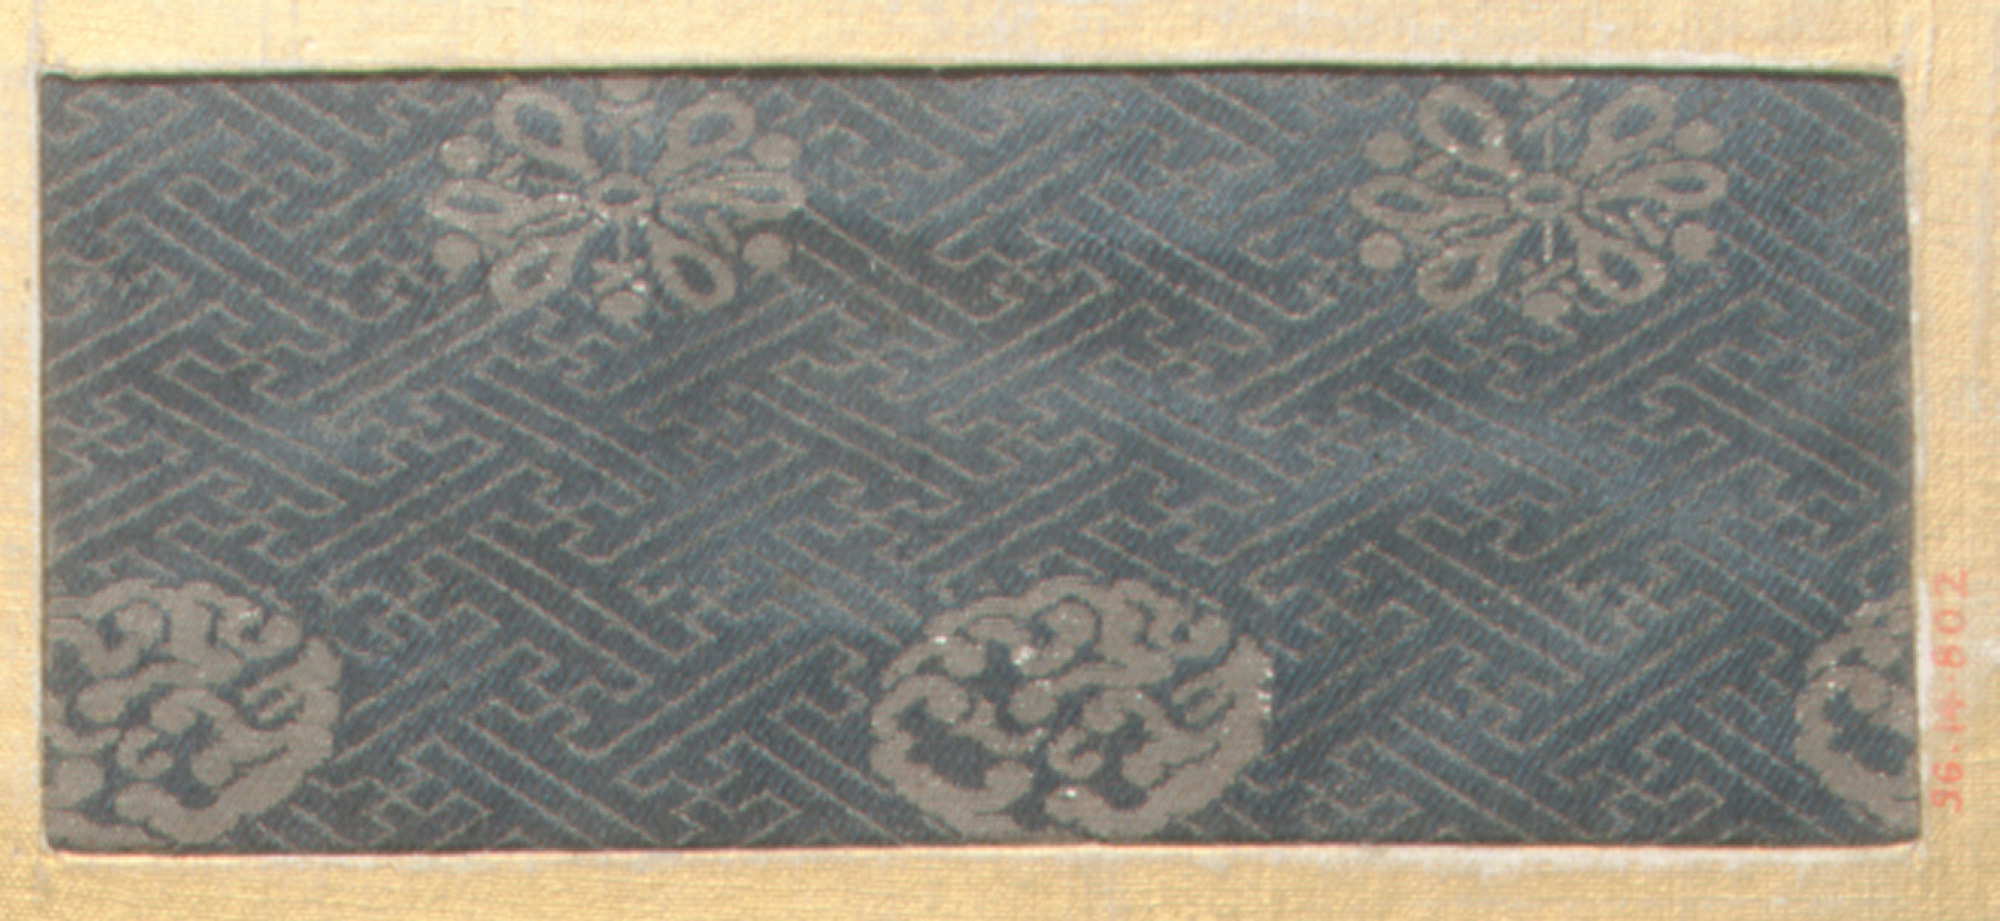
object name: piece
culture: japanese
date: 1701-1900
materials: silk